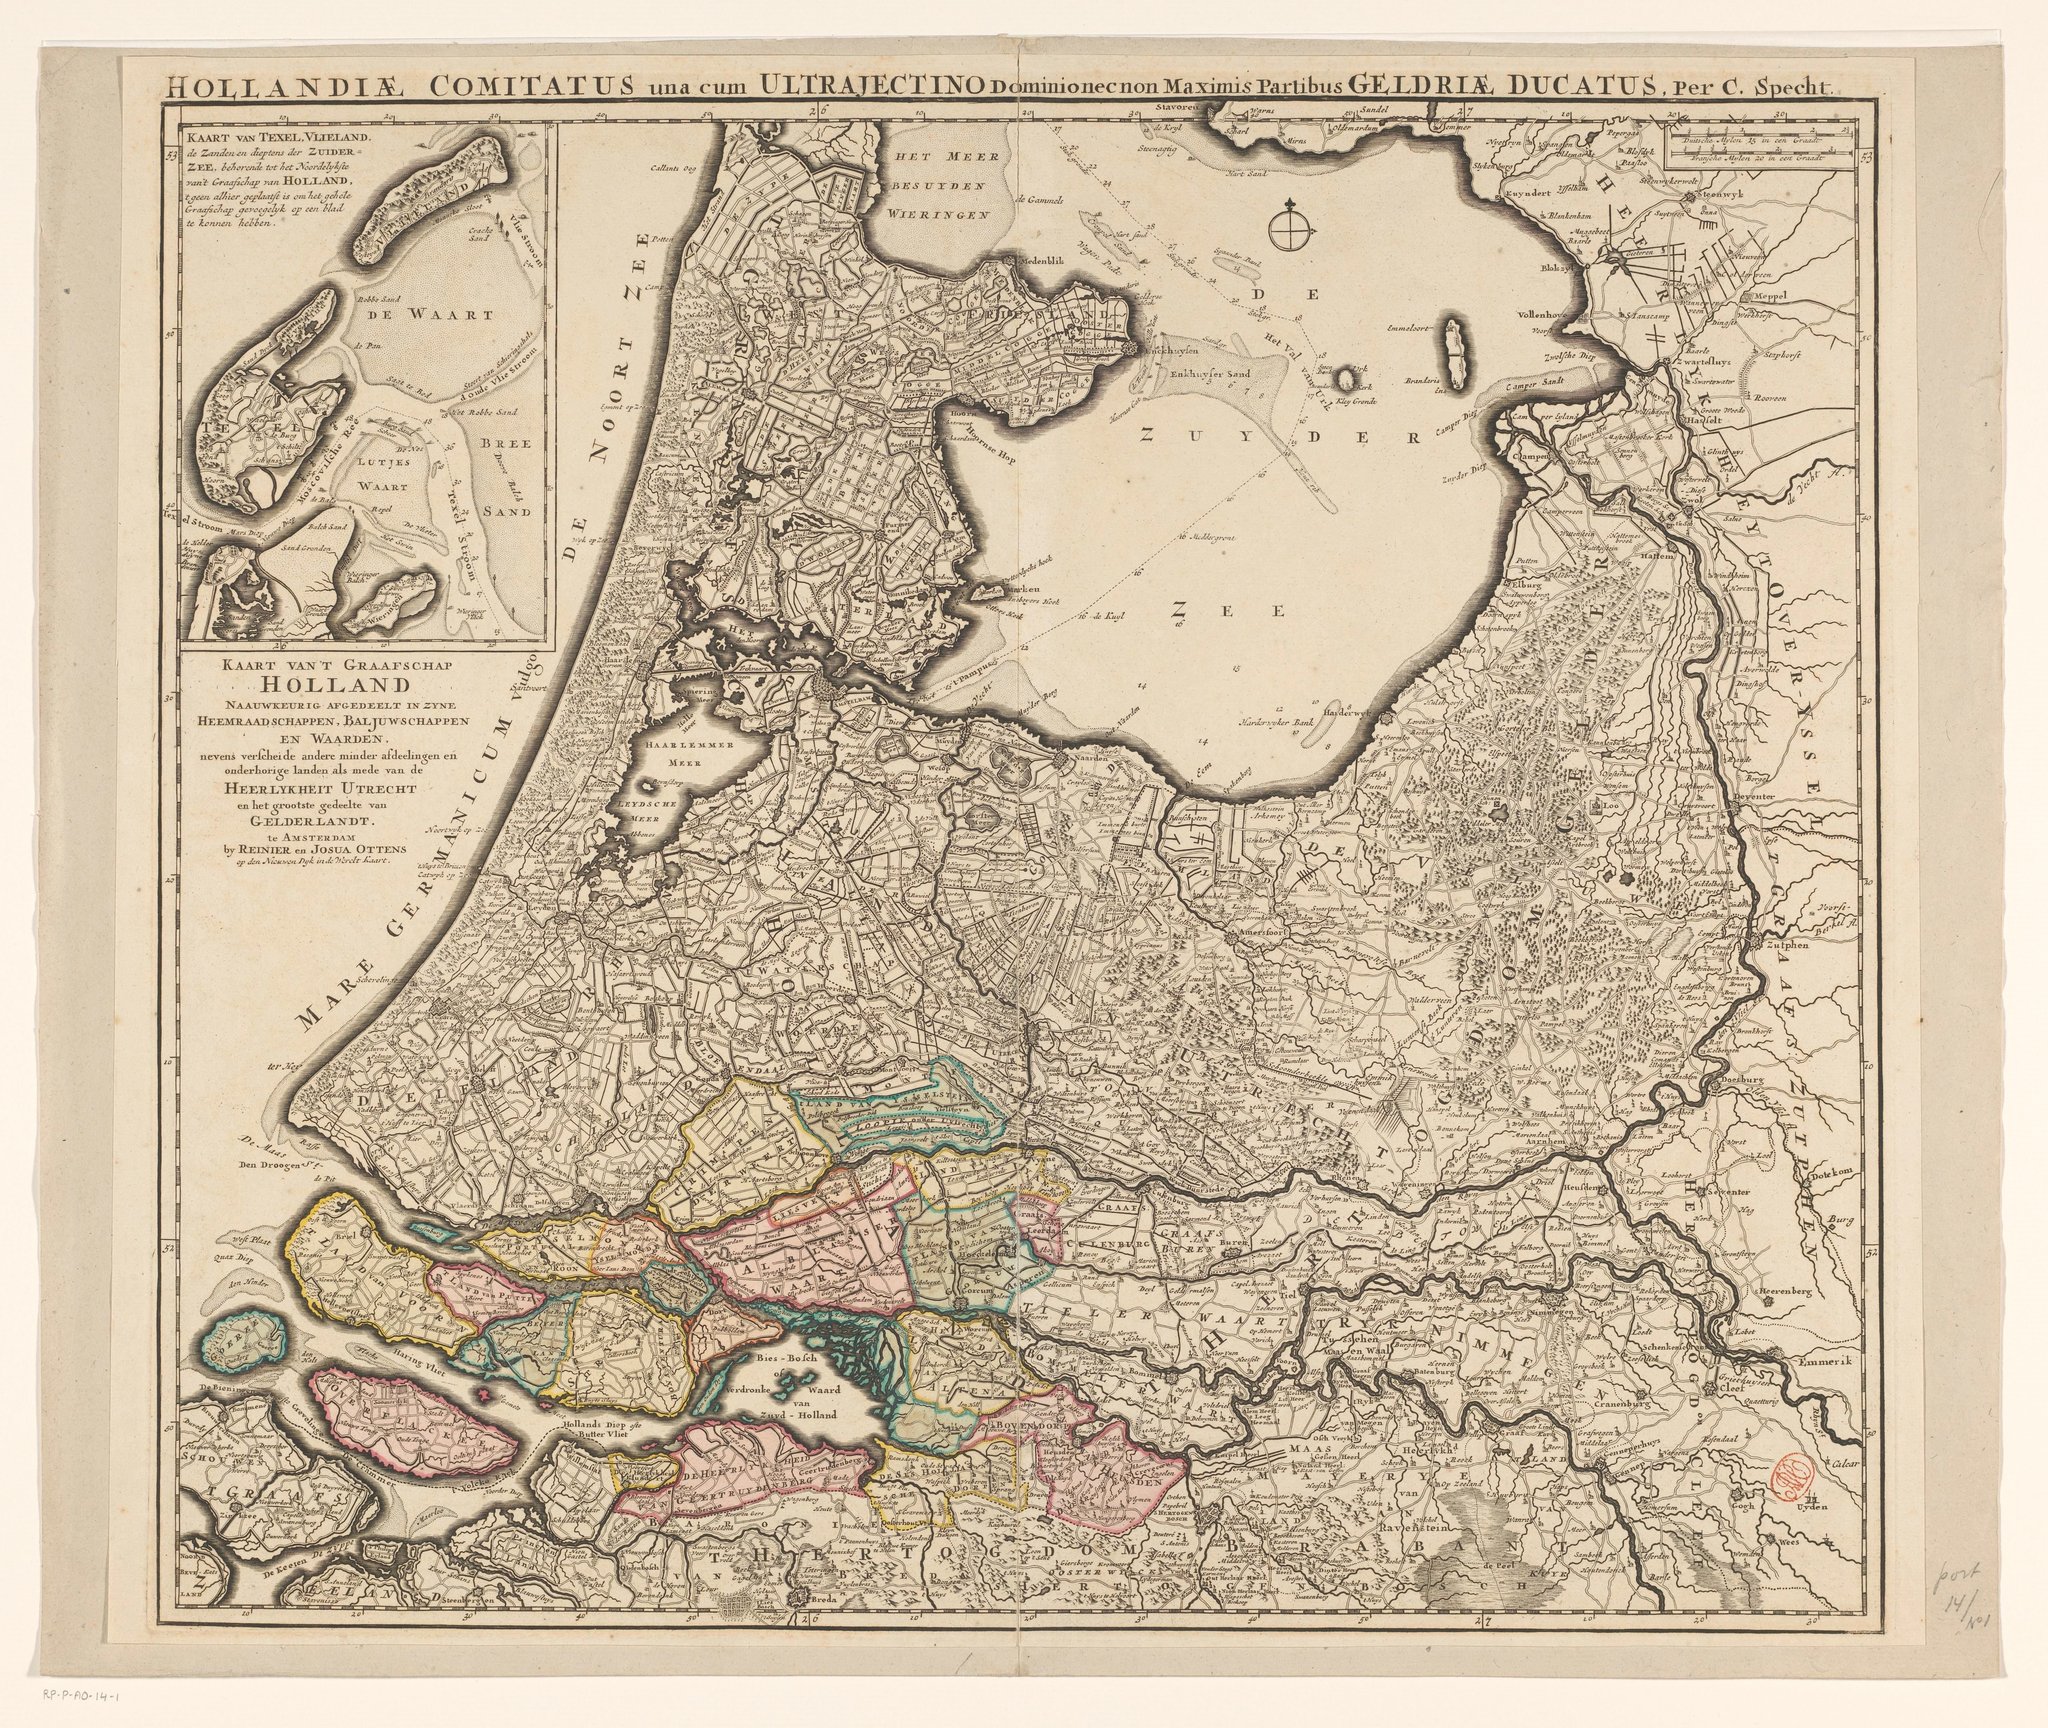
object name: print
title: Kaart van Holland, Utrecht en een deel van Gelderland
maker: caspar specht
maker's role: print maker, publisher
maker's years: 1654-1710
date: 1704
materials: paper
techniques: engraving, hand coloring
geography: utrecht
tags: maps of separate countries or regions, gelderland, holland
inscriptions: collector's mark: Lugt 195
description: Kaart van het graafschap Holland, de heerlijkheid Utrecht en het grootste deel van het hertogdom Gelderland. Linksboven een inzetkaart van Texel en Vlieland. Daaronder de Nederlandse titel. Rechtsboven twee schaalstokken: Duitsche mylen 15 in een graadt; Fransche mylen 20 in een graadt. Gradenverdeling langs de randen. Het zuidelijke deel van Zuid-Holland is gekleurd.